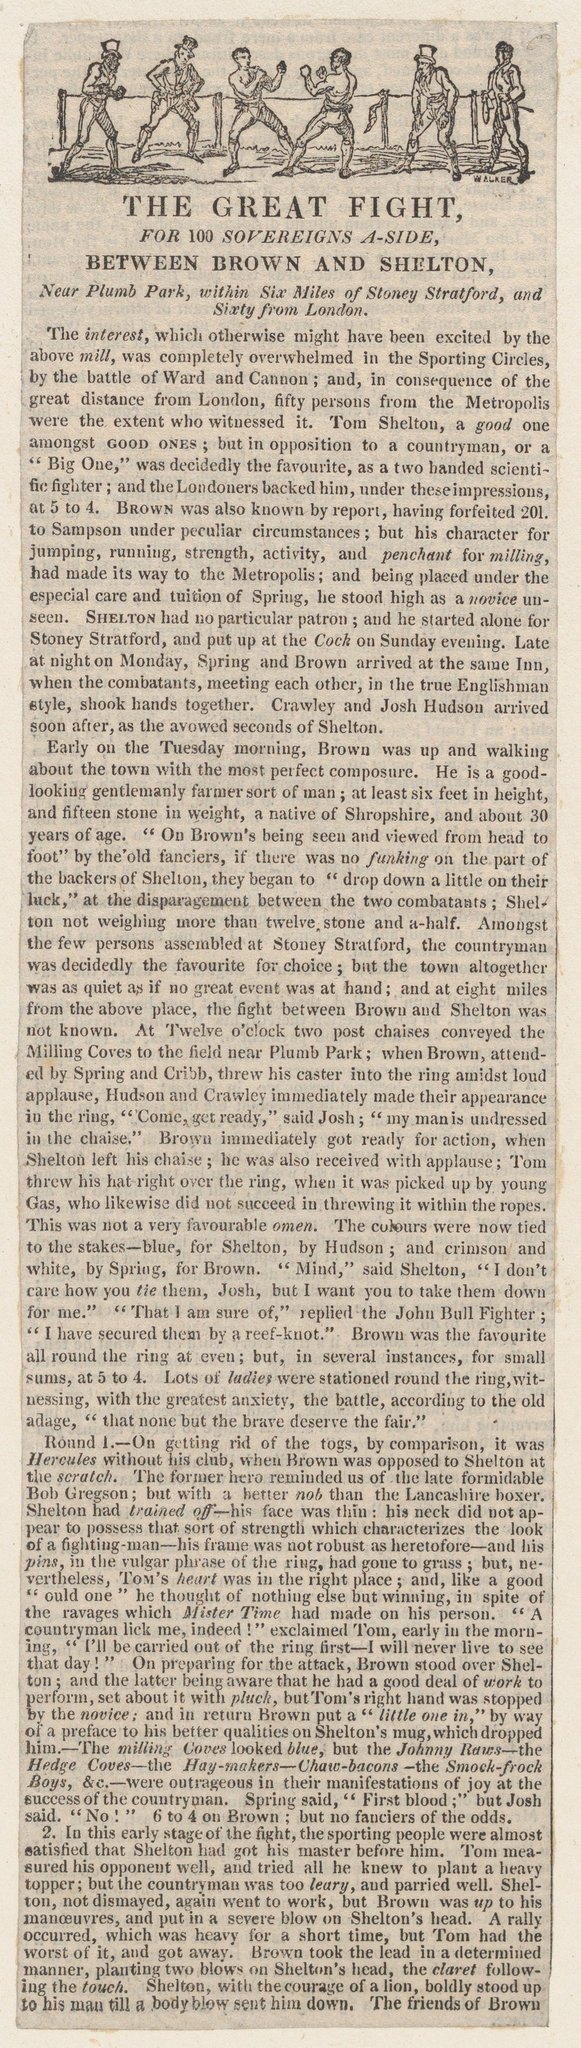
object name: print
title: The Great Fight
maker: william chester walker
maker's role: engraver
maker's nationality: british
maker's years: 1823-1872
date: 1824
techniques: woodcut